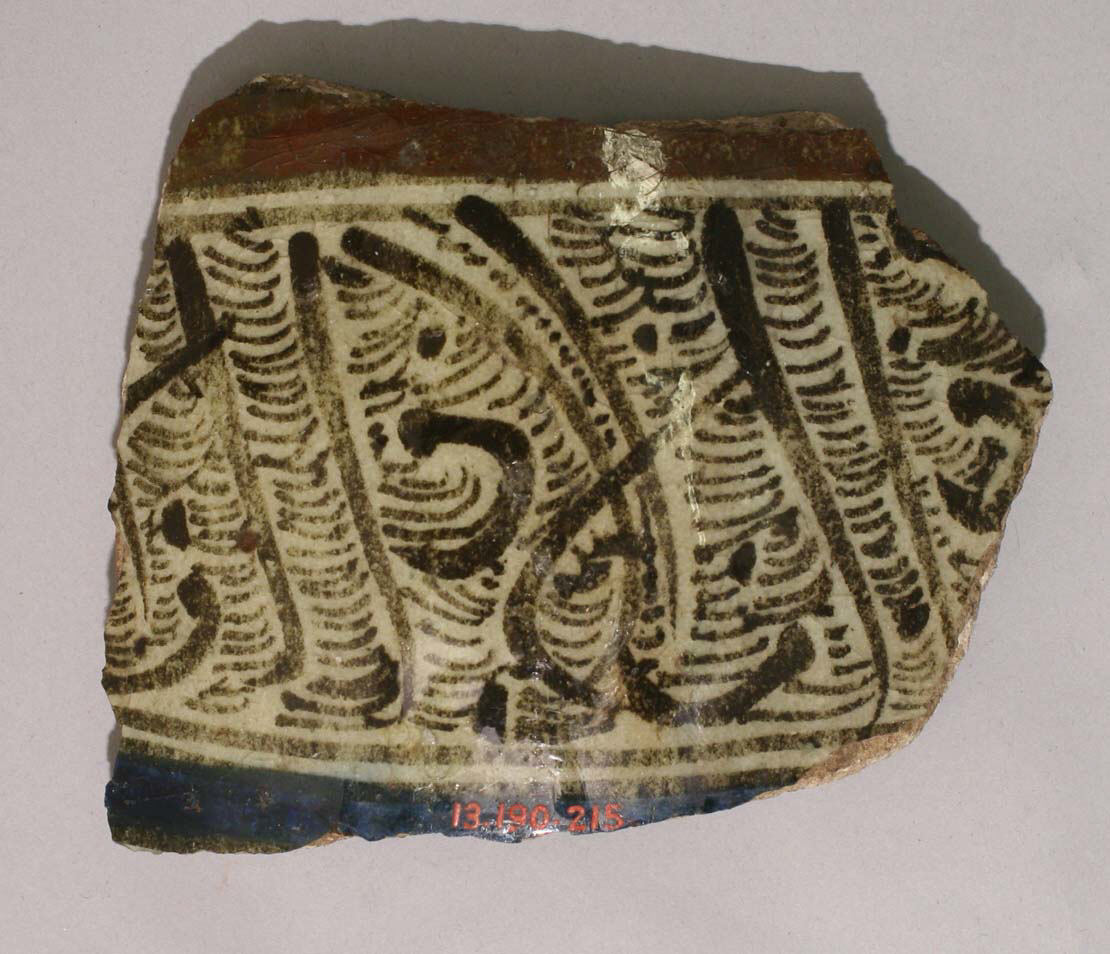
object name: ceramic fragment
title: Fragment of Dish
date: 1301-1400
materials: stonepaste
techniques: painting, polychrome, underglaze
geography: syria